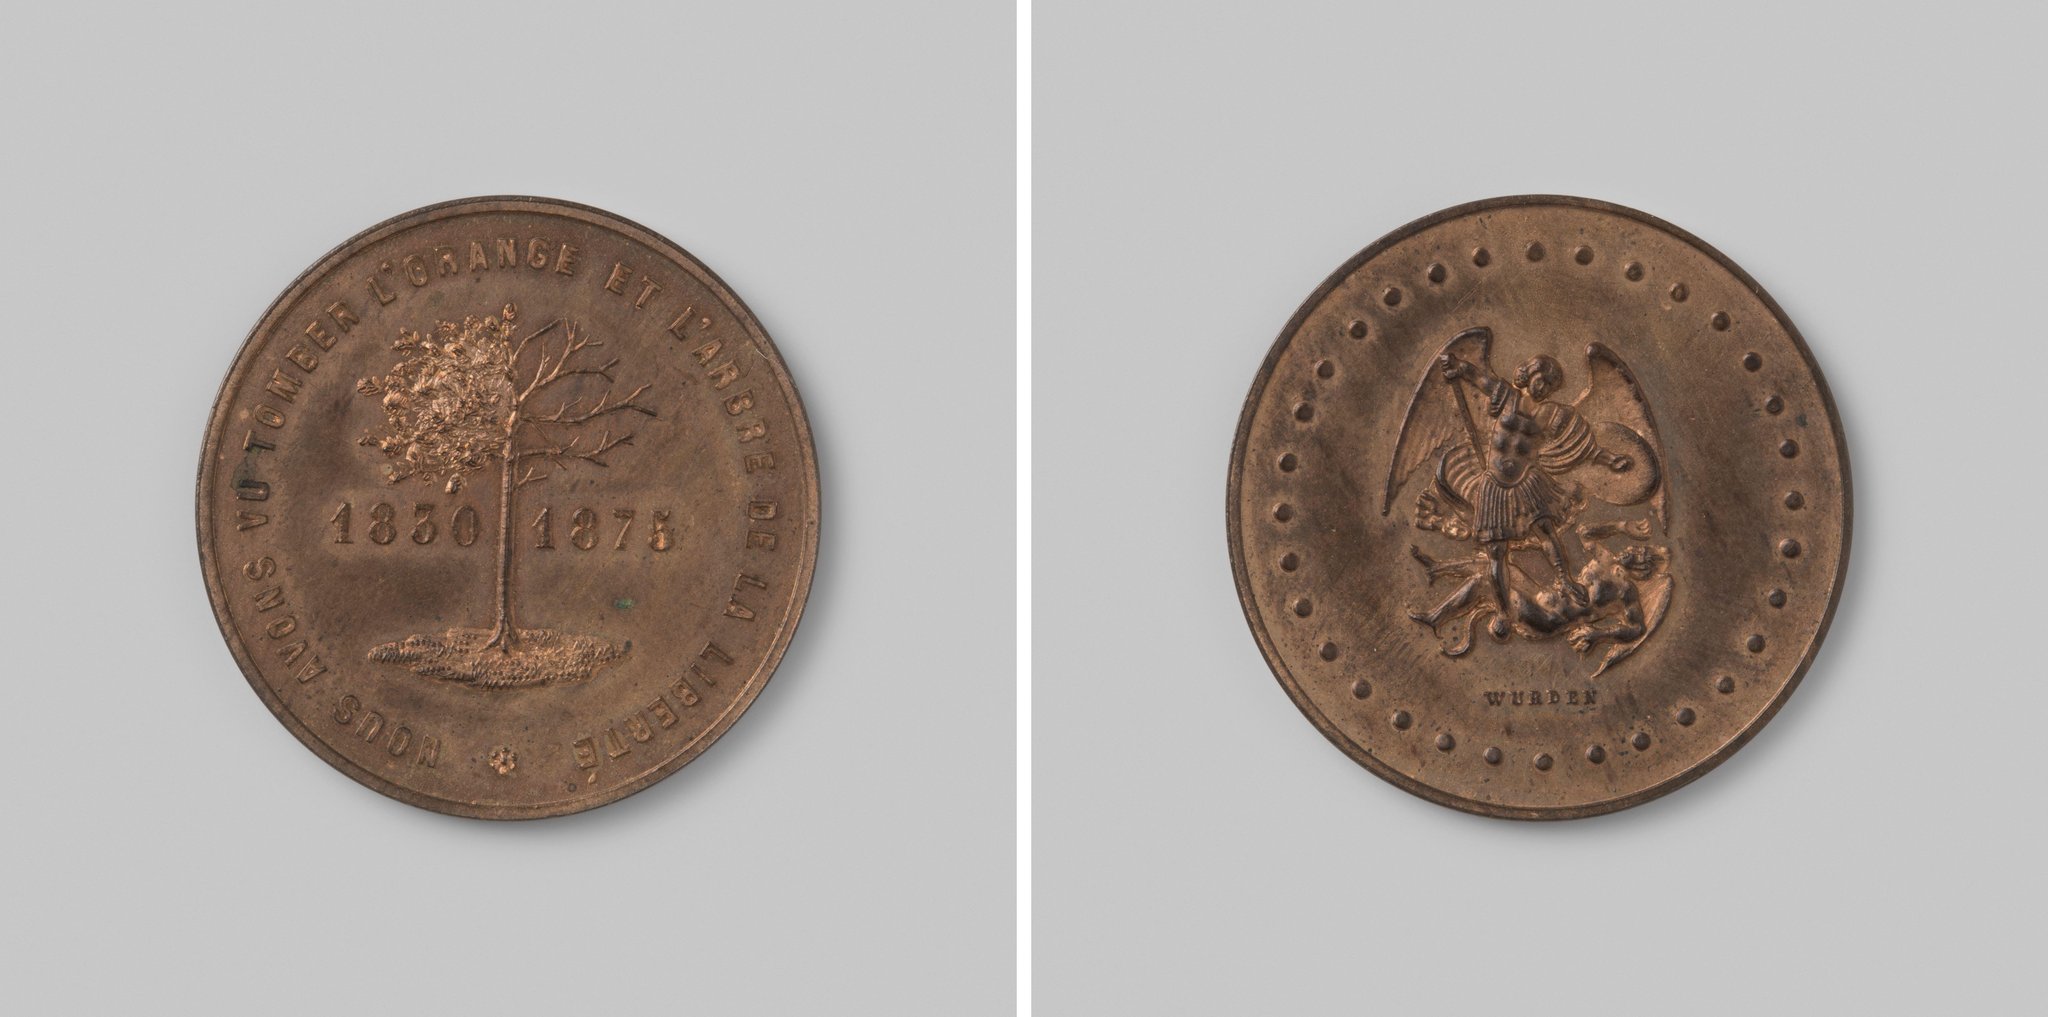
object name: satirical medal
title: Huis van Oranje-Nassau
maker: henri charles wurden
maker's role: medailleur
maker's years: 1847-1908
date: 1875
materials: copper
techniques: striking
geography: brussels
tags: oranje-nassau, huis oranje-nassau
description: Koperen penning. Voorzijde: boom, waarvan linkerhelft bladeren draagt en rechterhelft kale takken heeft, tussen twee jaartallen binnen omschrift. Keerzijde: engel, staat met voet op ter aarde liggende duivel, gereed om hem met zwaard te doorboren binnen rand van punten